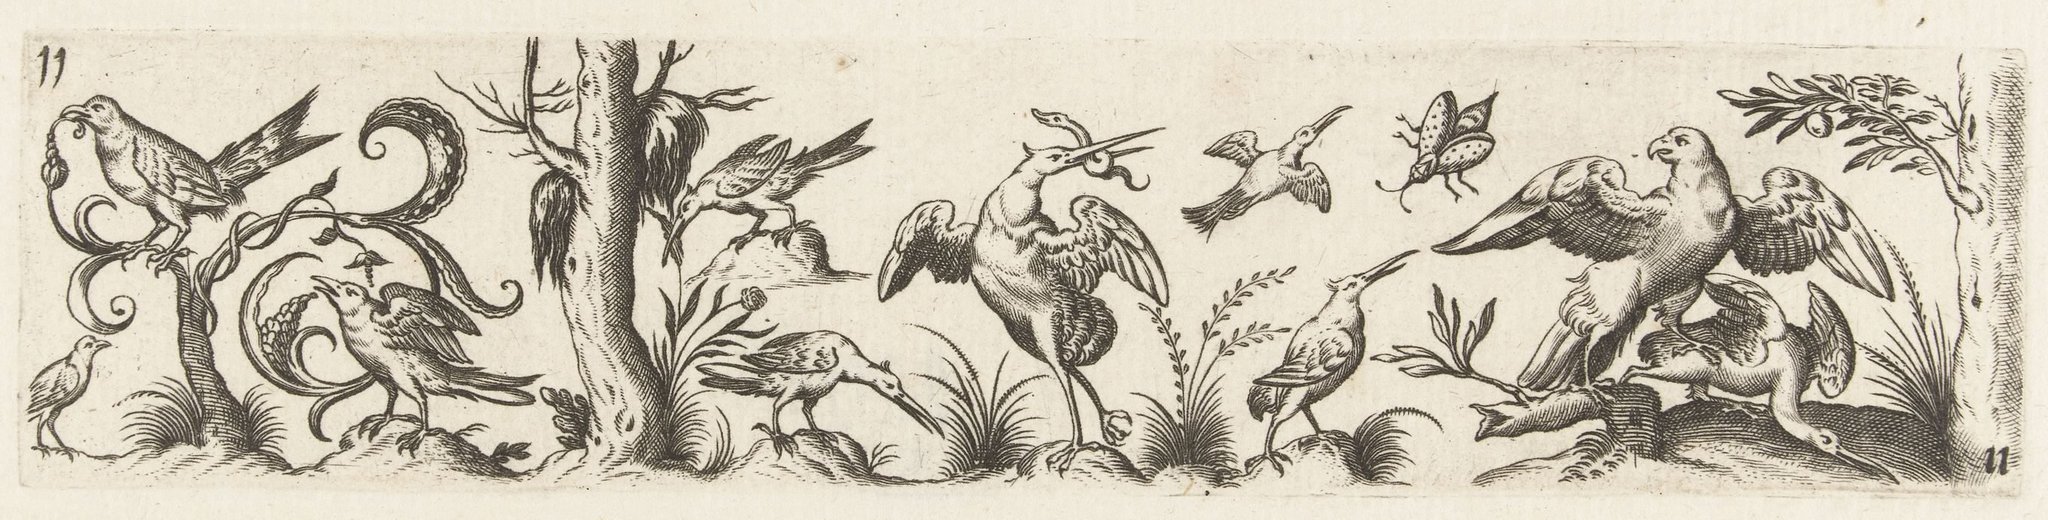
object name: print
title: Friezen met vogels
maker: Anonymous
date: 1530-1580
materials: paper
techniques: engraving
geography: netherlands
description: Aan het rechter uiteinde van het fries staat een boom. Links staan een boom en een struikje. Nummer 11 van 4 genummerde bladen uit een serie van 12?